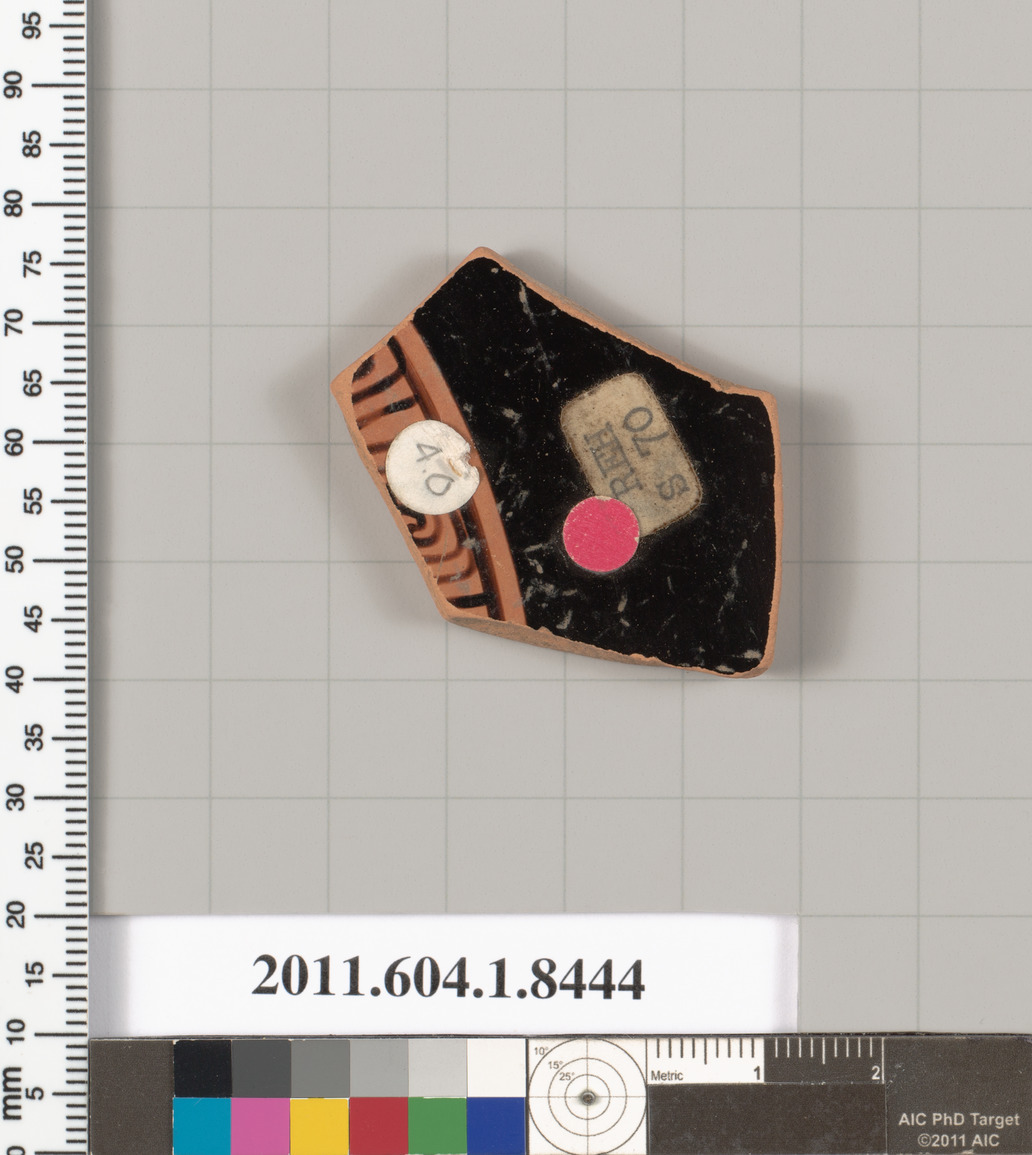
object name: kylix fragment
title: Terracotta fragment of a kylix (drinking cup)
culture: greek, attic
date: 400-376 BCE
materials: terracotta